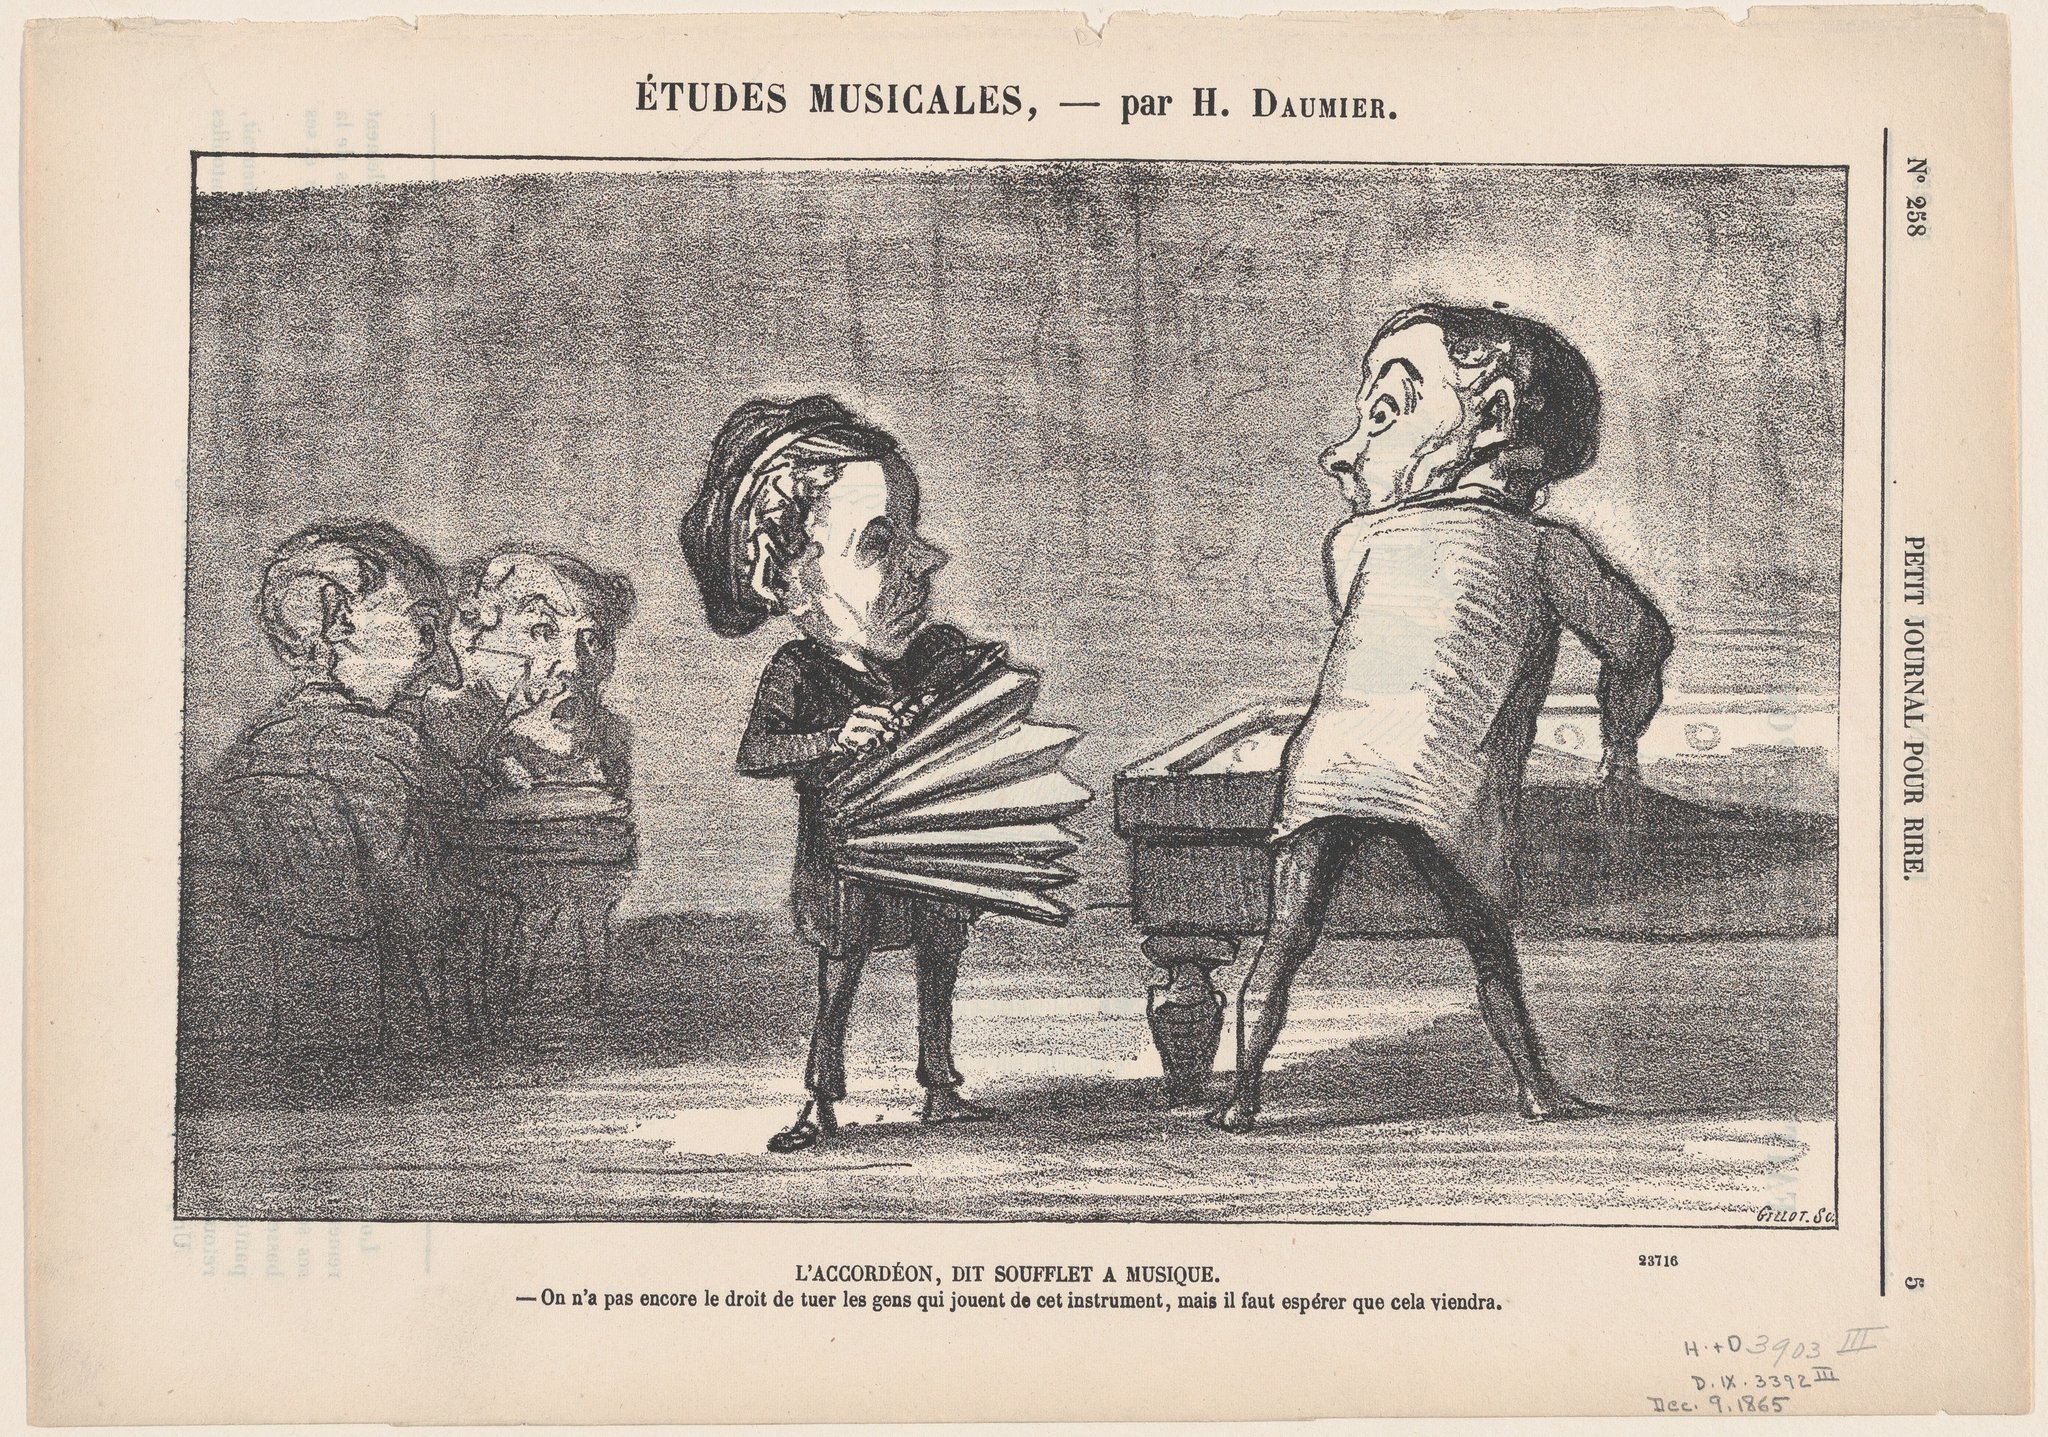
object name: print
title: The Accordion: A Blow to Music, from "Musical Studies"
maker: honoré daumier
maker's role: artist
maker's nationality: french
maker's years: 1808-1879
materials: paper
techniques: lithograph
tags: men,music,accordions,musicians